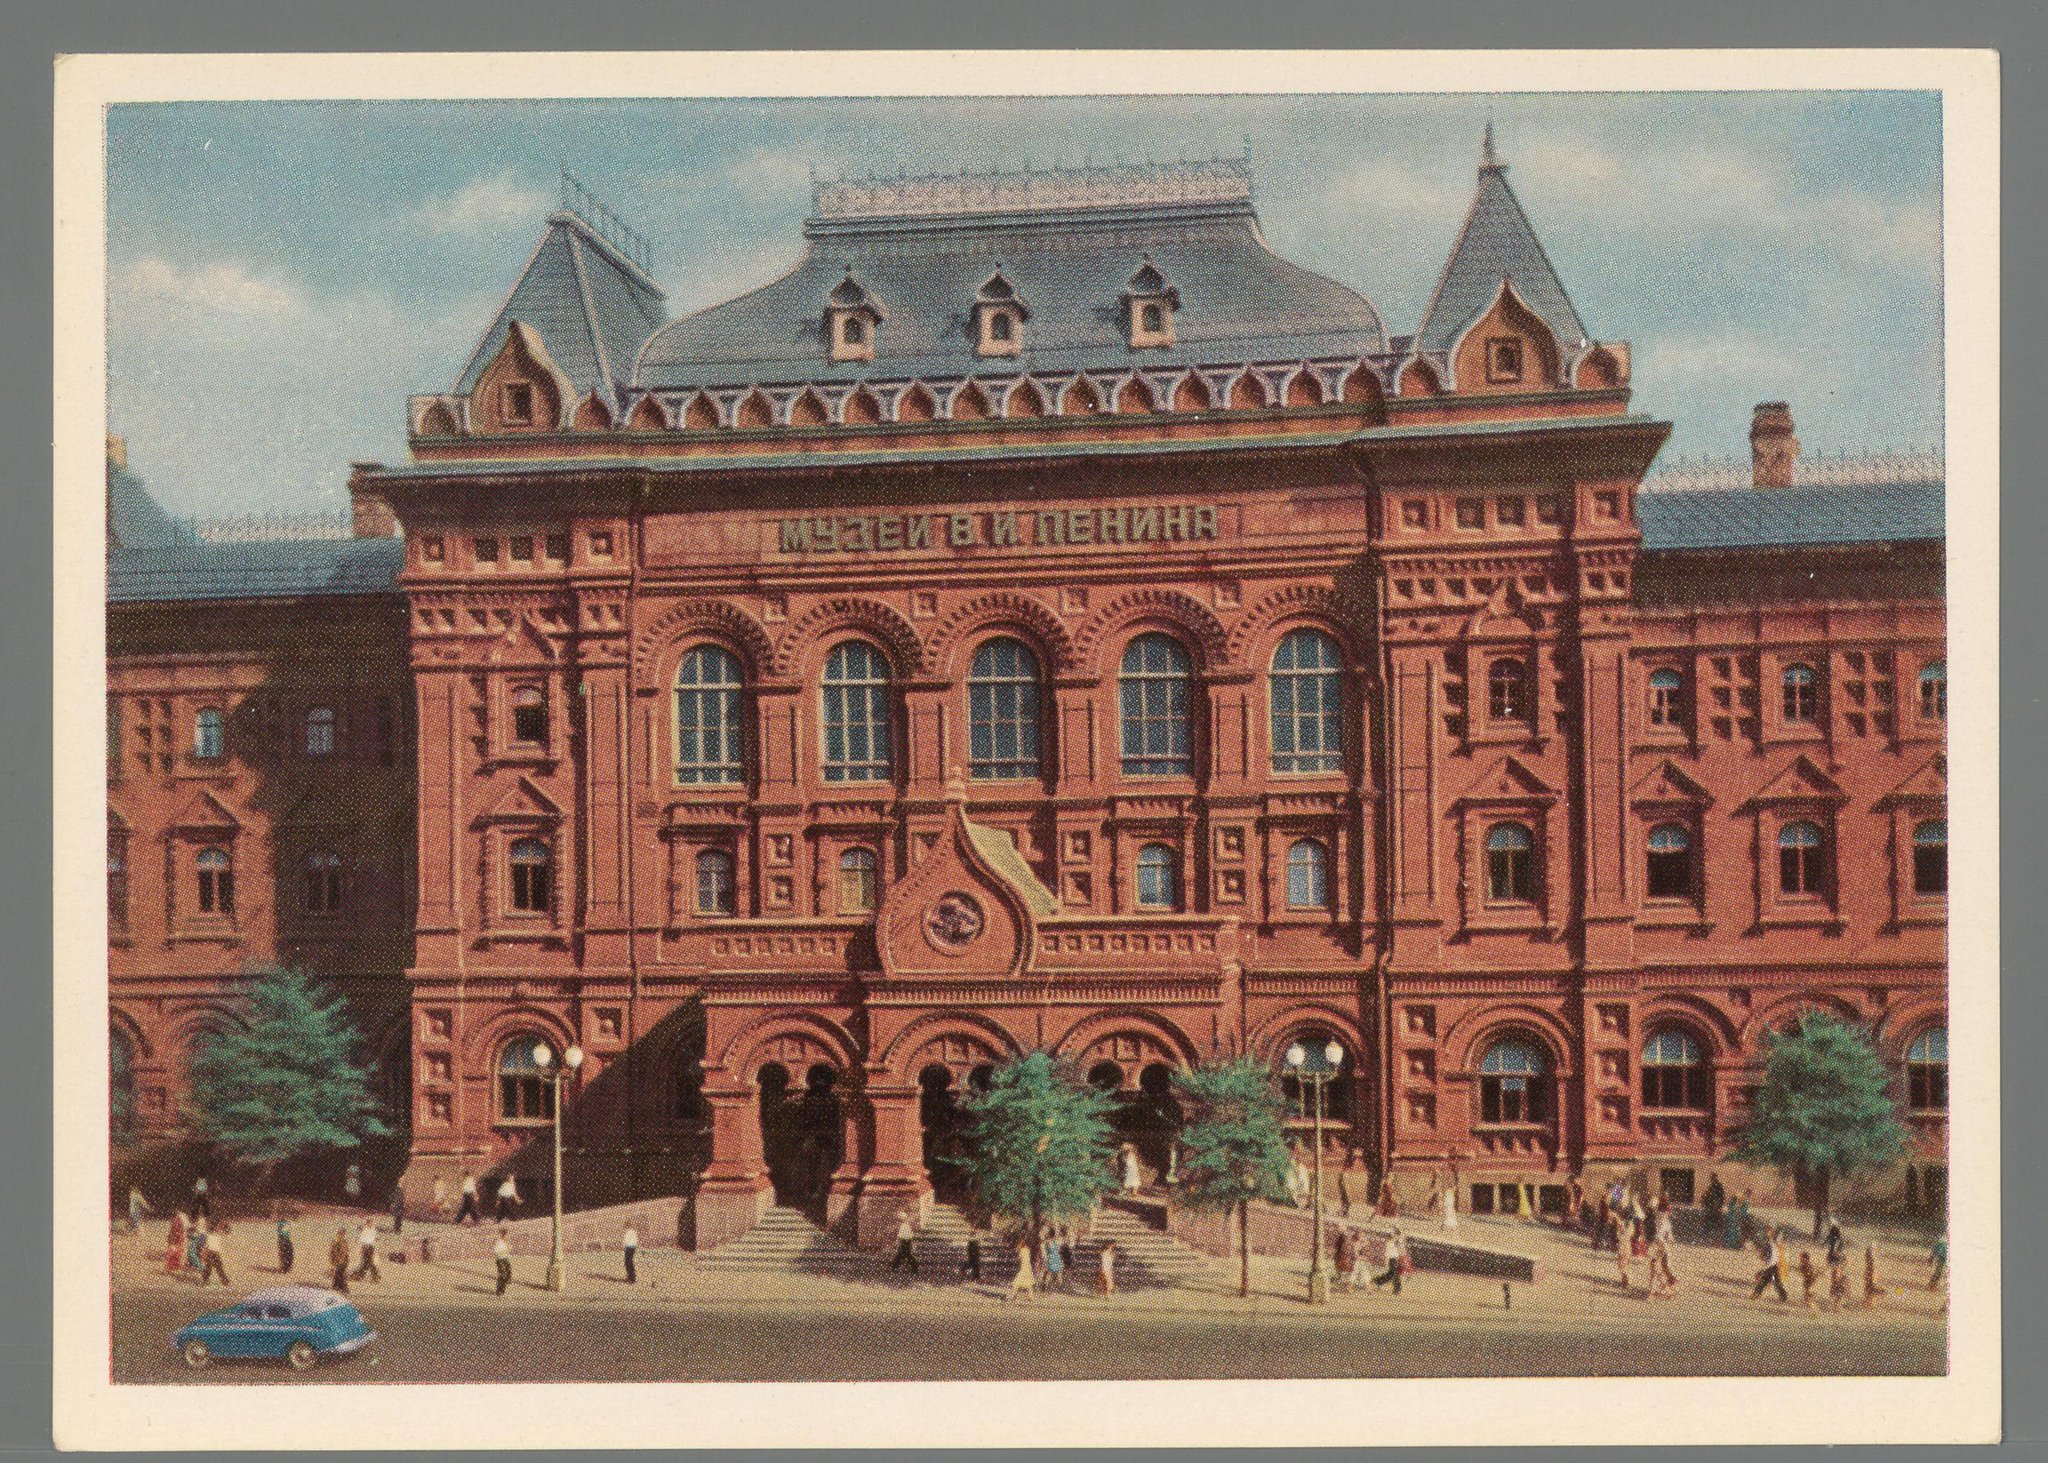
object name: ansichtkaart, prentbriefkaart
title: Moscow. The Lenin Central Museum / Moskau. Zentrales Lenin-Museum / Moscou. Musée Central Lénine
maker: Anonymous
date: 1956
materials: cardboard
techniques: color autotype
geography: moscow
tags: permanent exhibition, museum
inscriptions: date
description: De titel op object staat ook in het Russisch.